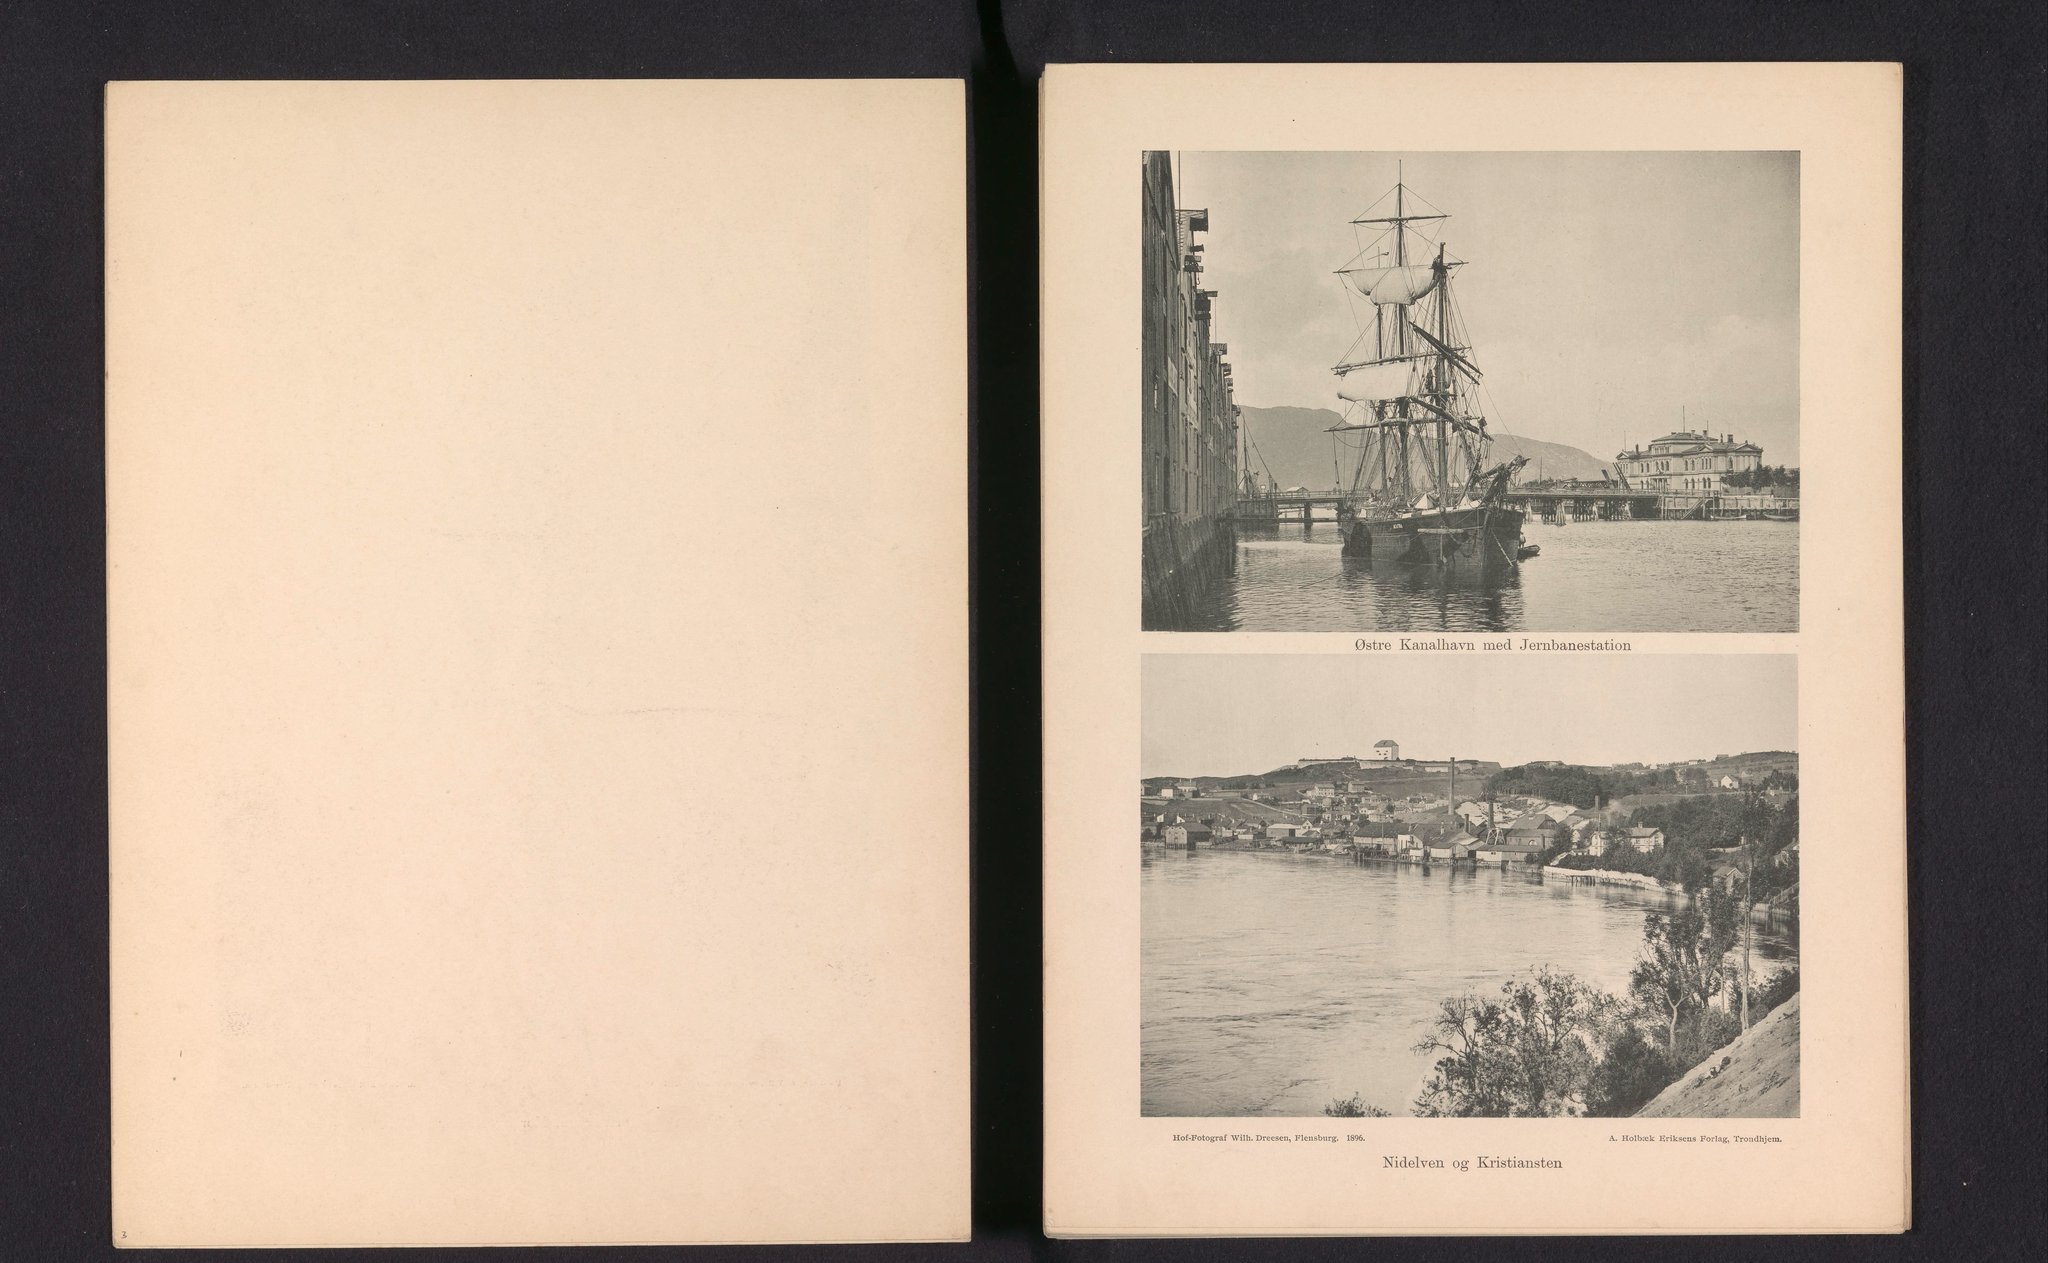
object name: page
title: Østre Kanalhavn med Jernbaestation Nidelven og Kristiansten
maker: wilhelm dreesen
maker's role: fotograaf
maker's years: 1840-1926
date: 1896-1897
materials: paper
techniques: photograph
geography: trondheim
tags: harbour, fortress, ships (in general), station; shelter (railway, tramway)